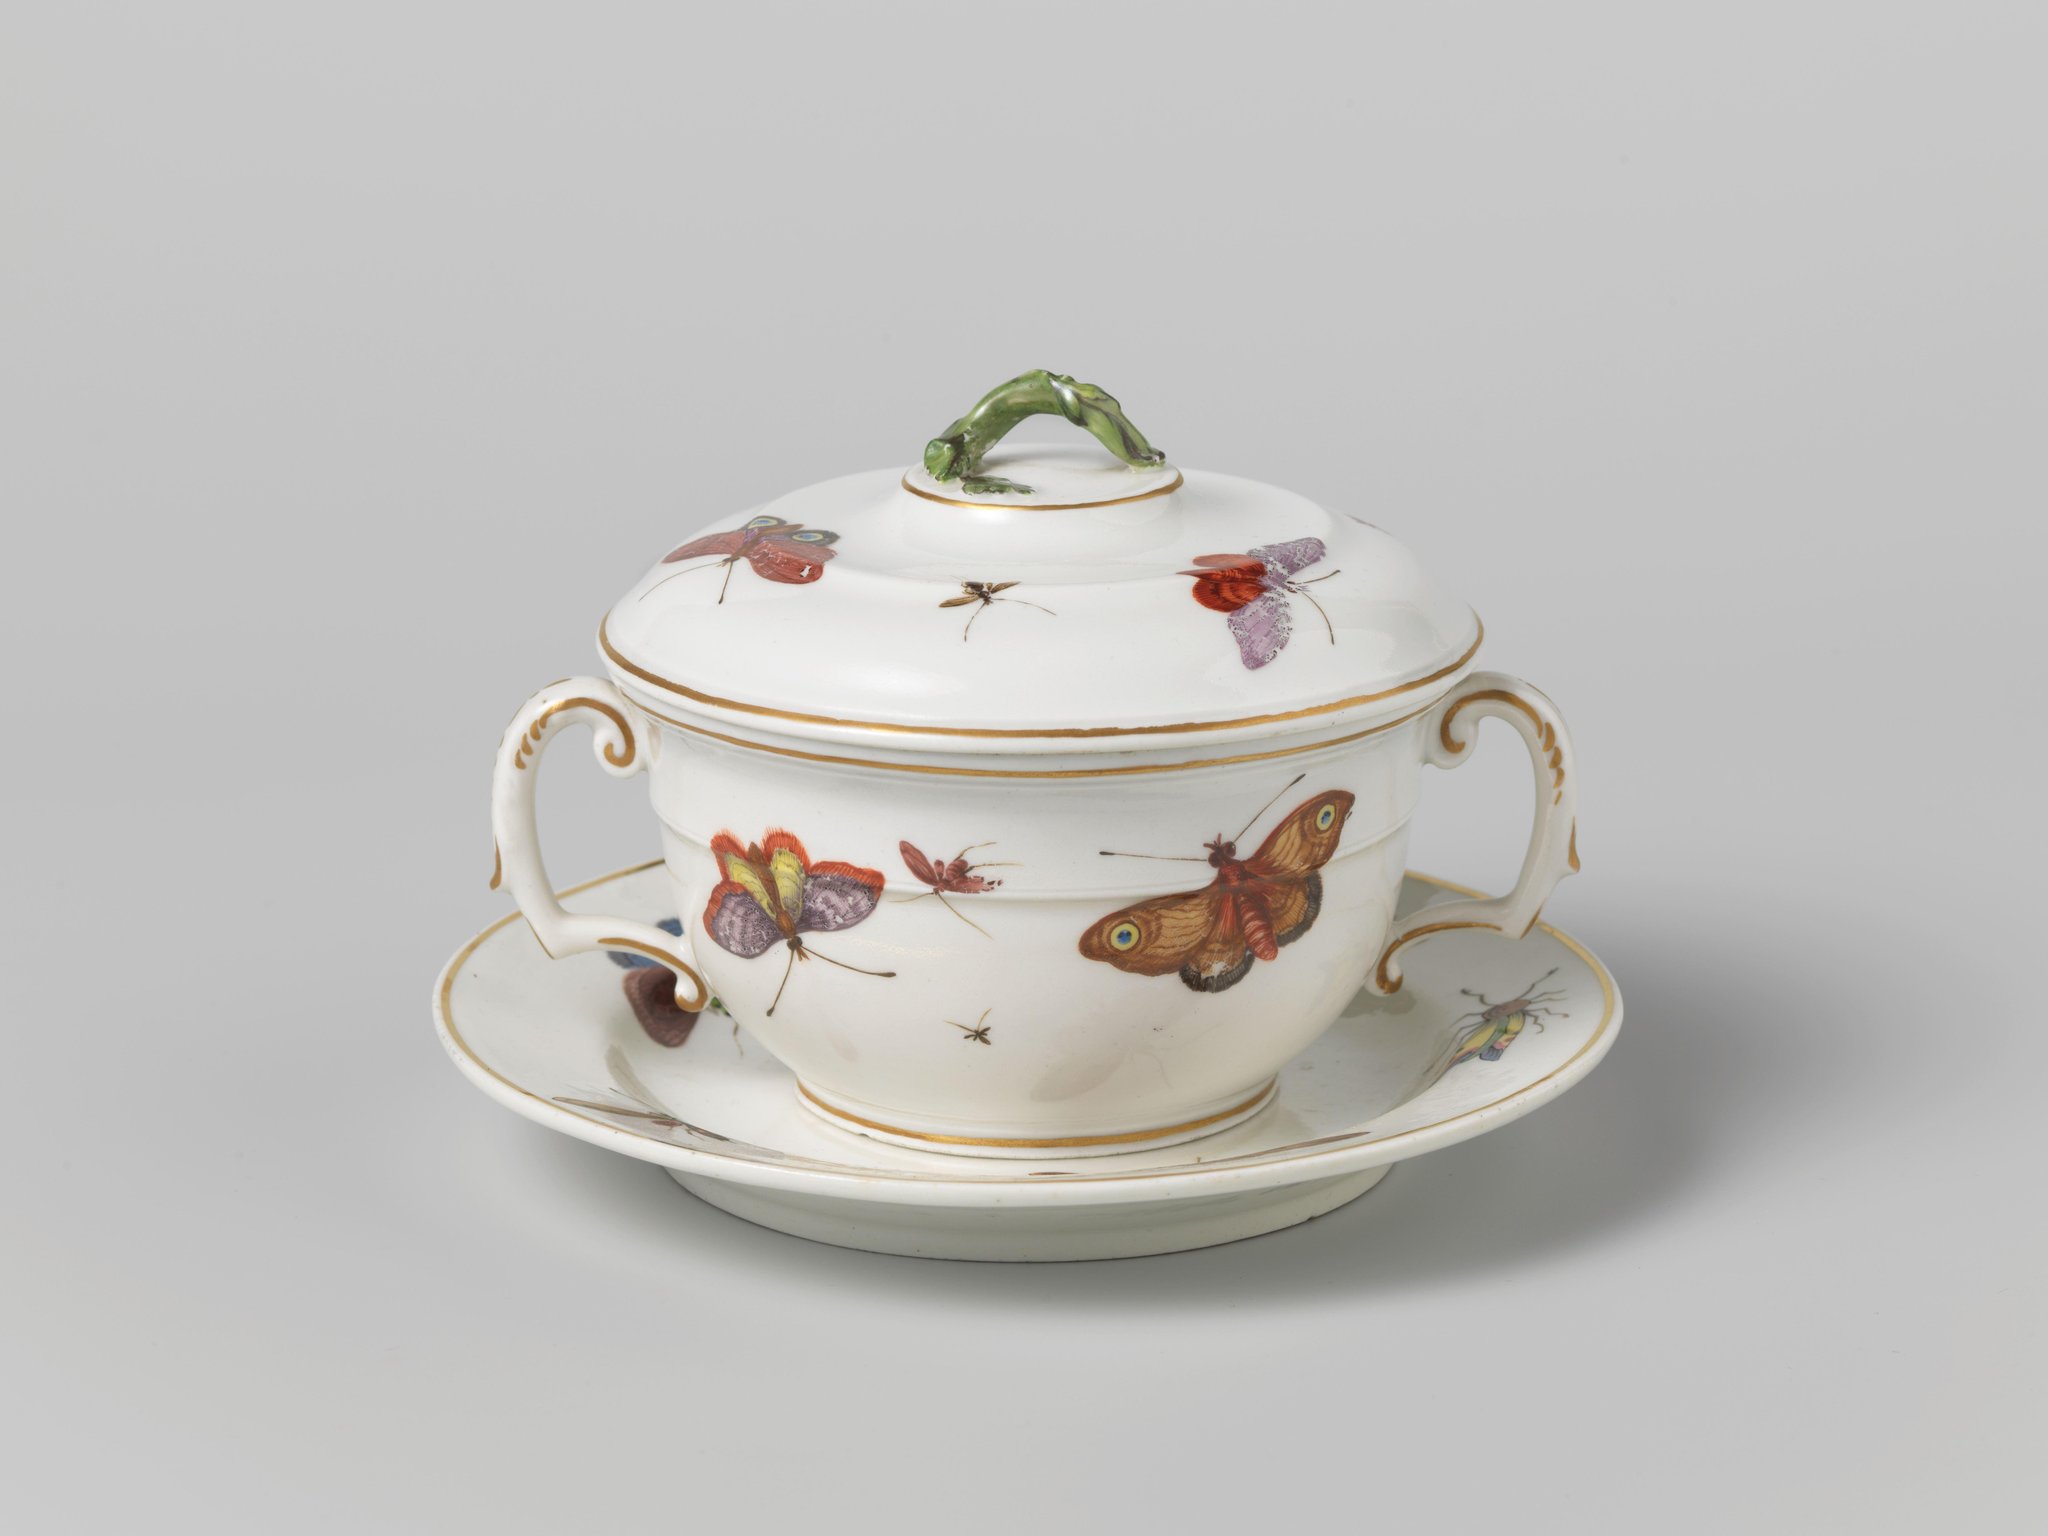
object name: tureen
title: Terrine met onderschotel, beschilderd met vlinders en insecten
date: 1778-1782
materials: porcelain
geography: loosdrecht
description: Terrine met onderschotel van porselein. De dekselknop bestaat uit een groene tak met blaadje. Alle delen veelkleurig beschilderd met vlinders en insecten. Langs de randen gouden biezen, de oren versierd in goud.